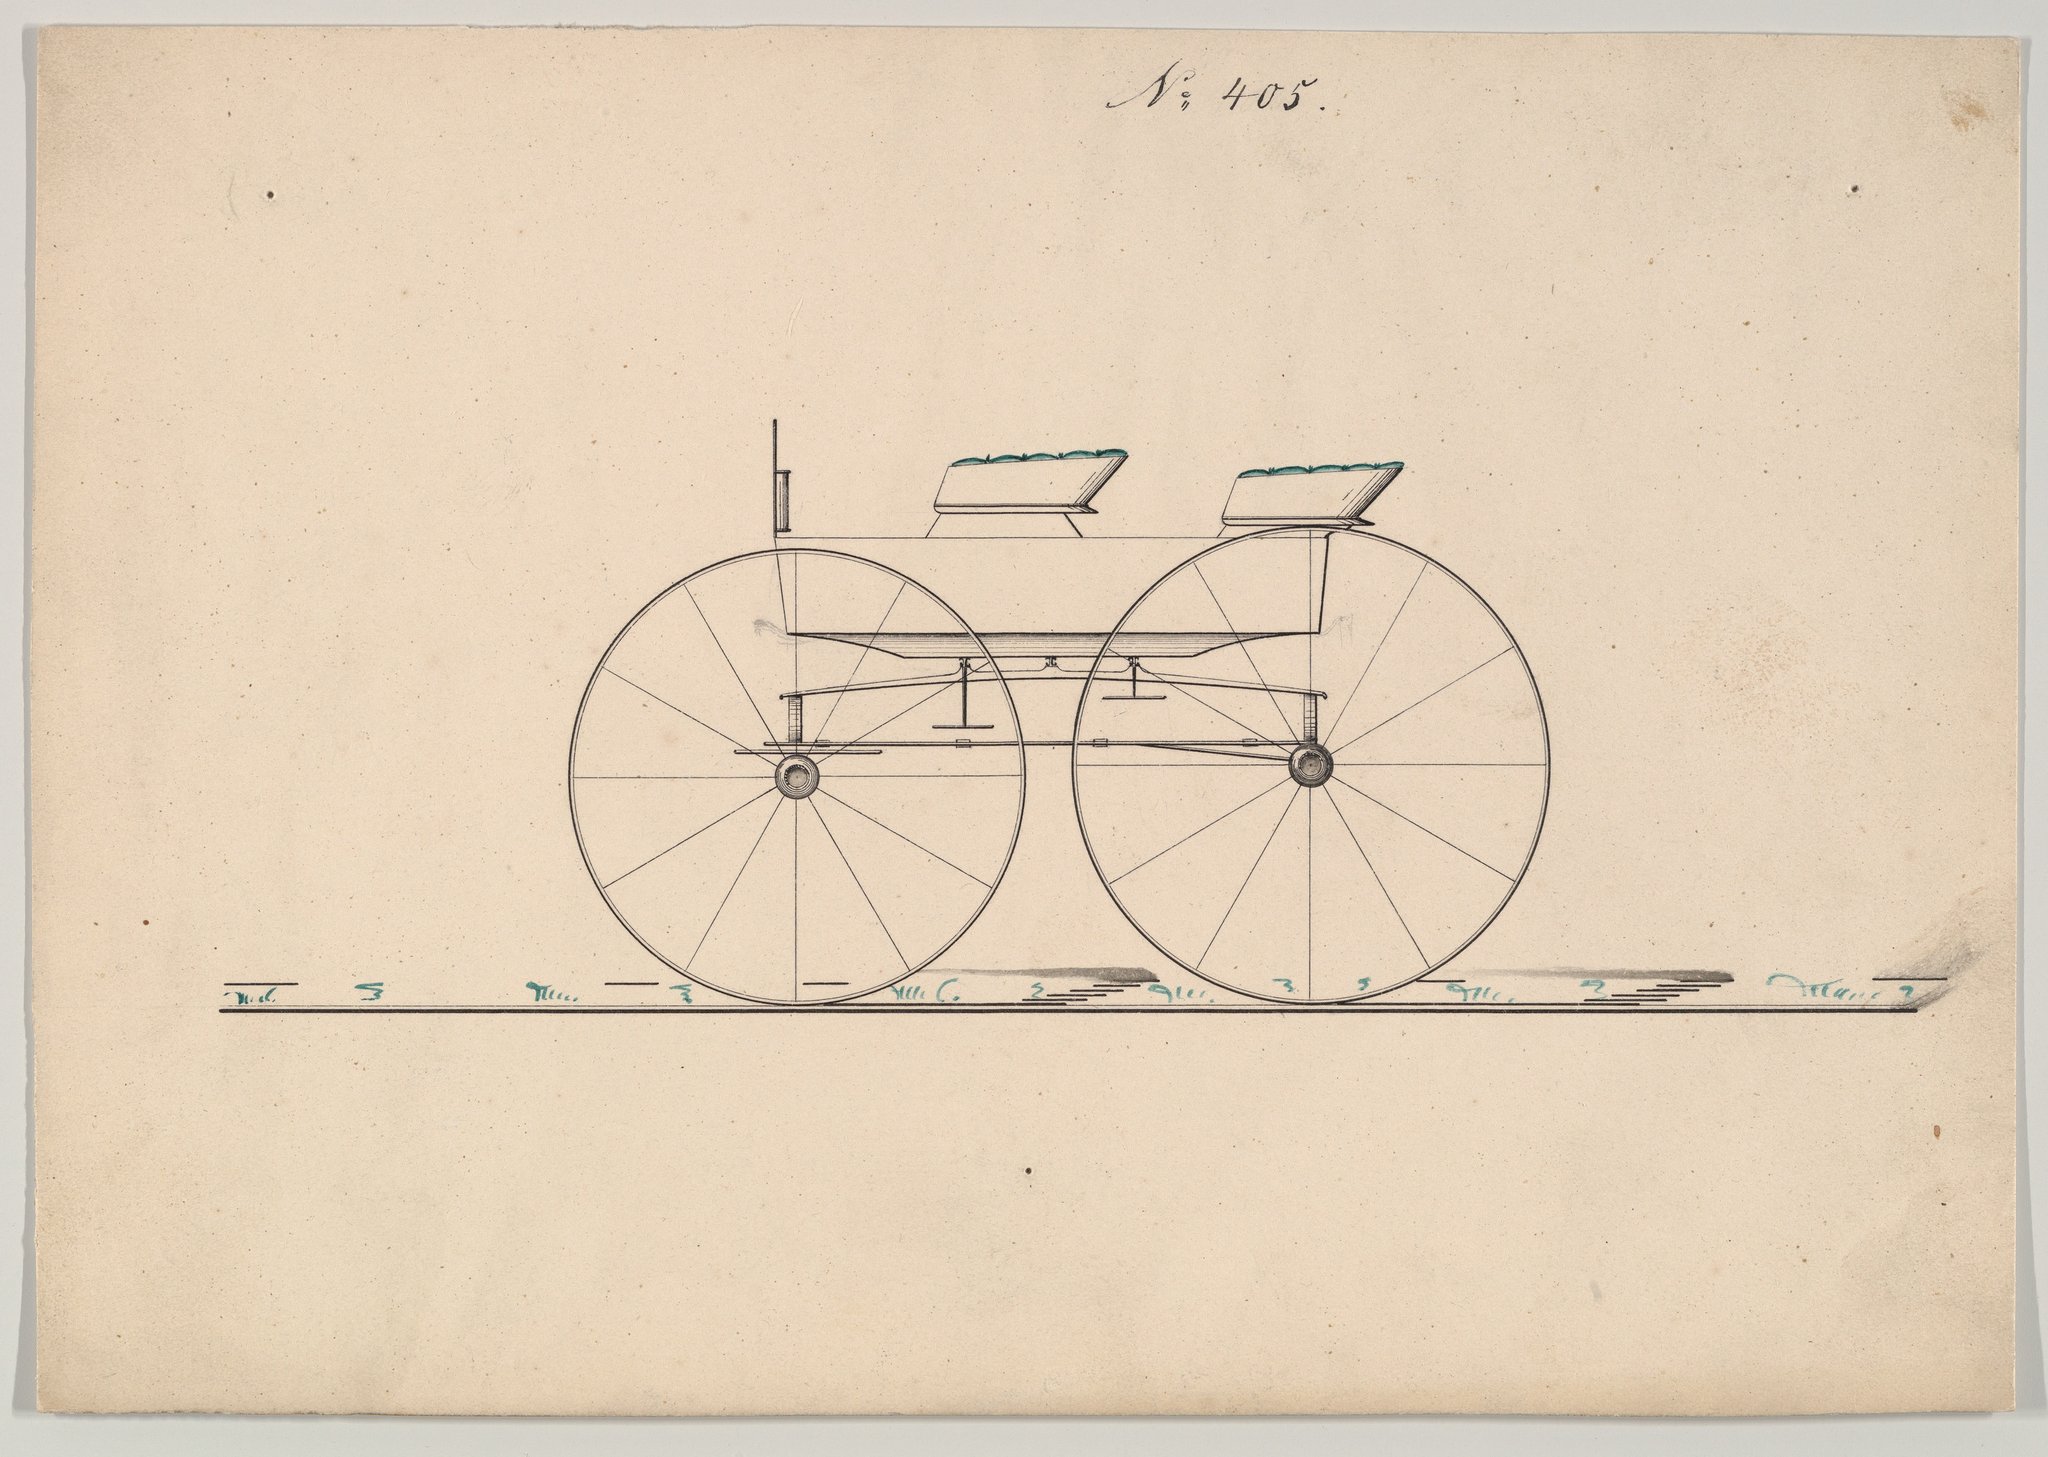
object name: drawing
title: Wagon #405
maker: brewster & co.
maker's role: manufacturer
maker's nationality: american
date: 1865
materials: ink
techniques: pen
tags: carriages